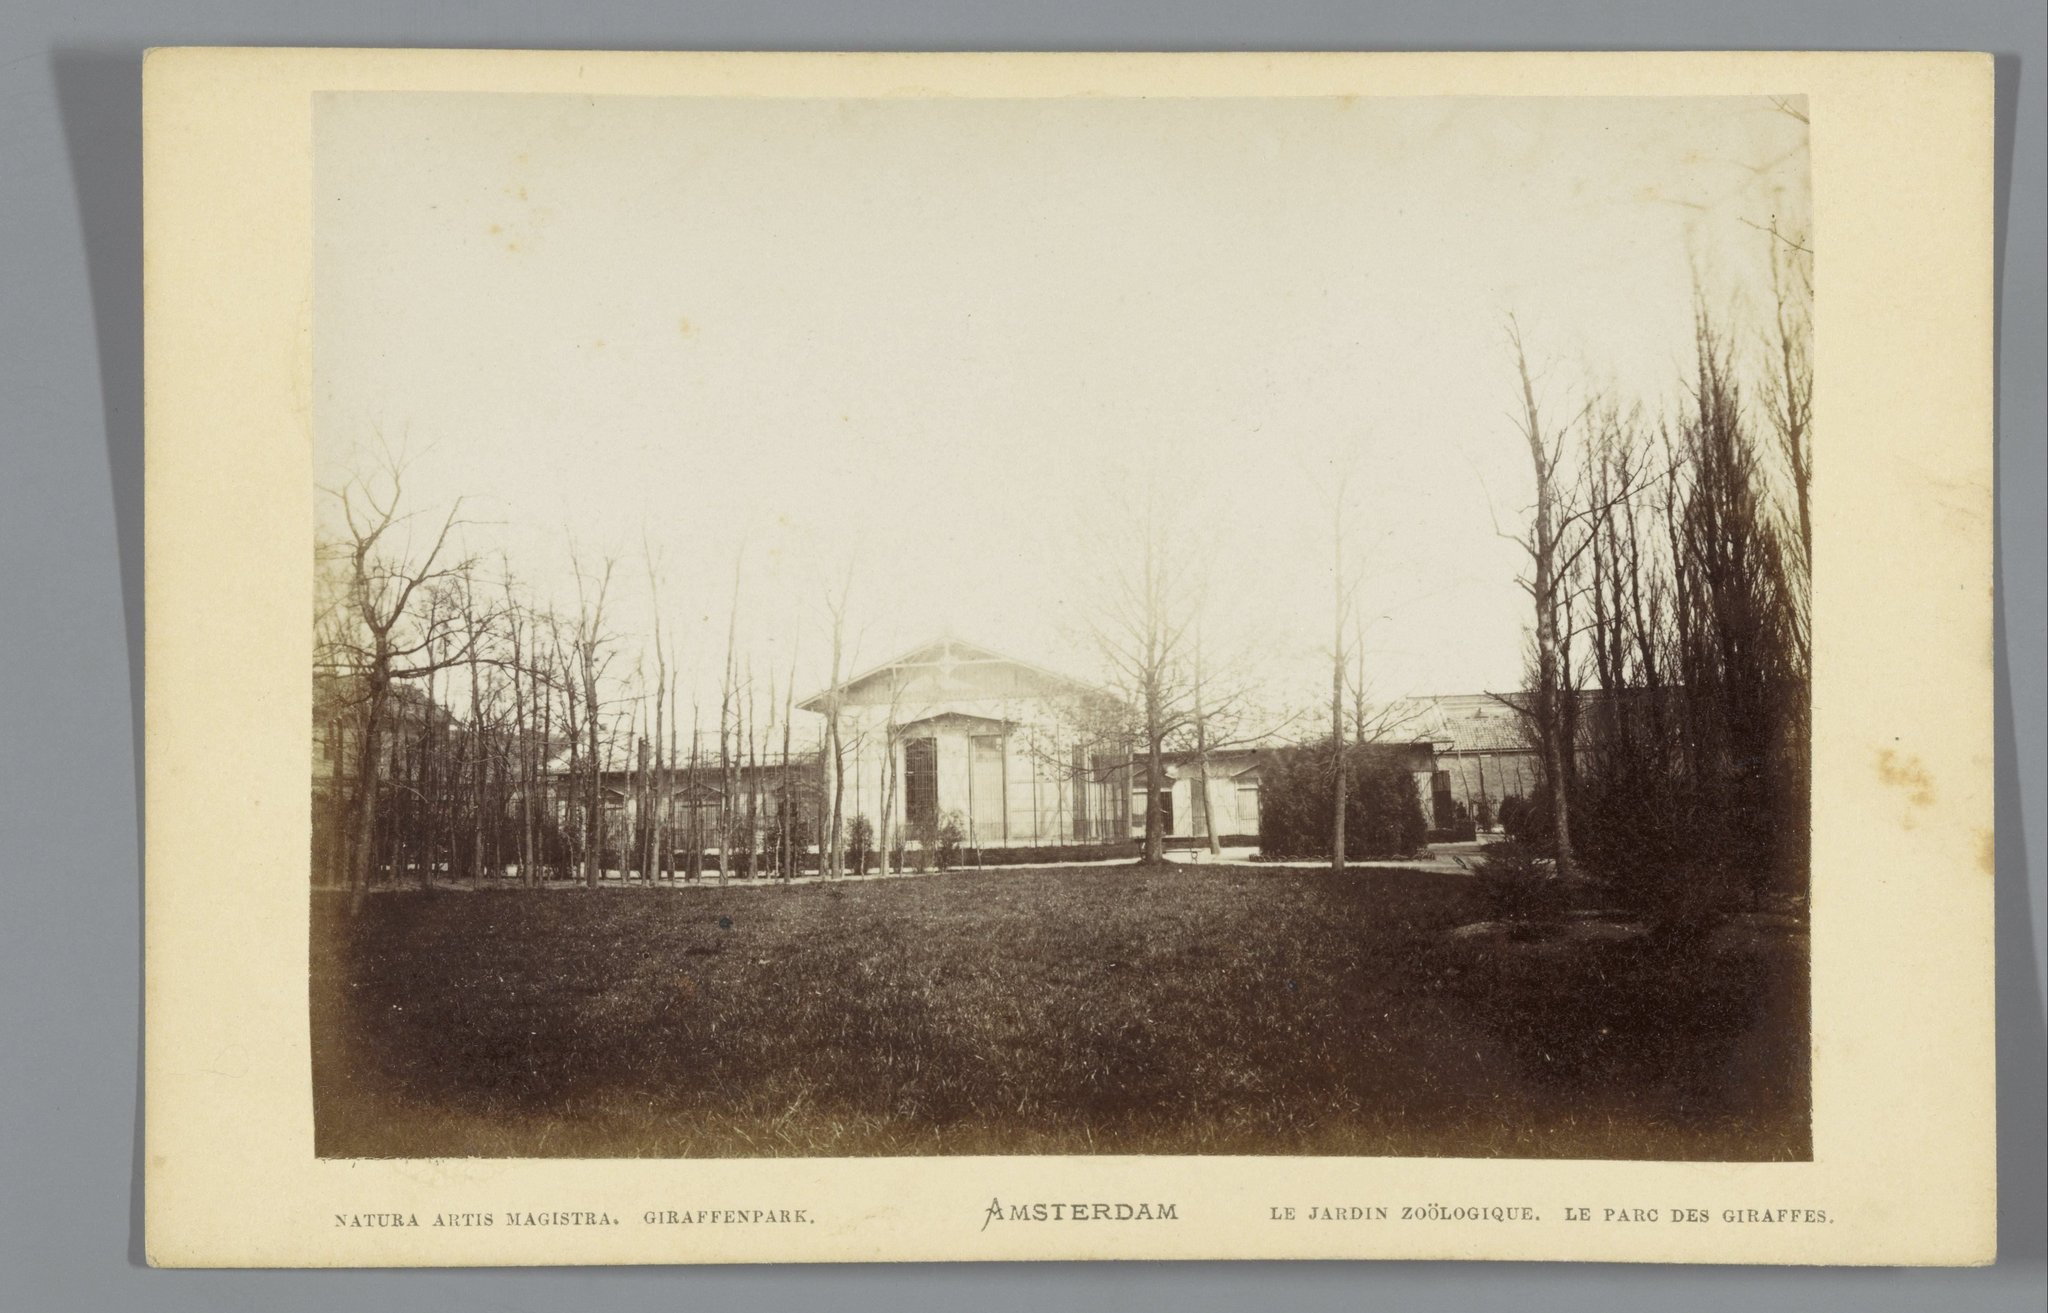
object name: cabinet photograph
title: Natura Artis Magistra. Giraffenpark / Le jardin zoölogique. Le parc des giraffes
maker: andries jager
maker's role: publisher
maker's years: 1825-1905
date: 1860-1890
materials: cardboard, photographic support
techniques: albumen print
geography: amsterdam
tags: zoological garden, zoo, seen as place where non-domestic animals are kept (+ accomodations for animals), hoofed animals: giraffe